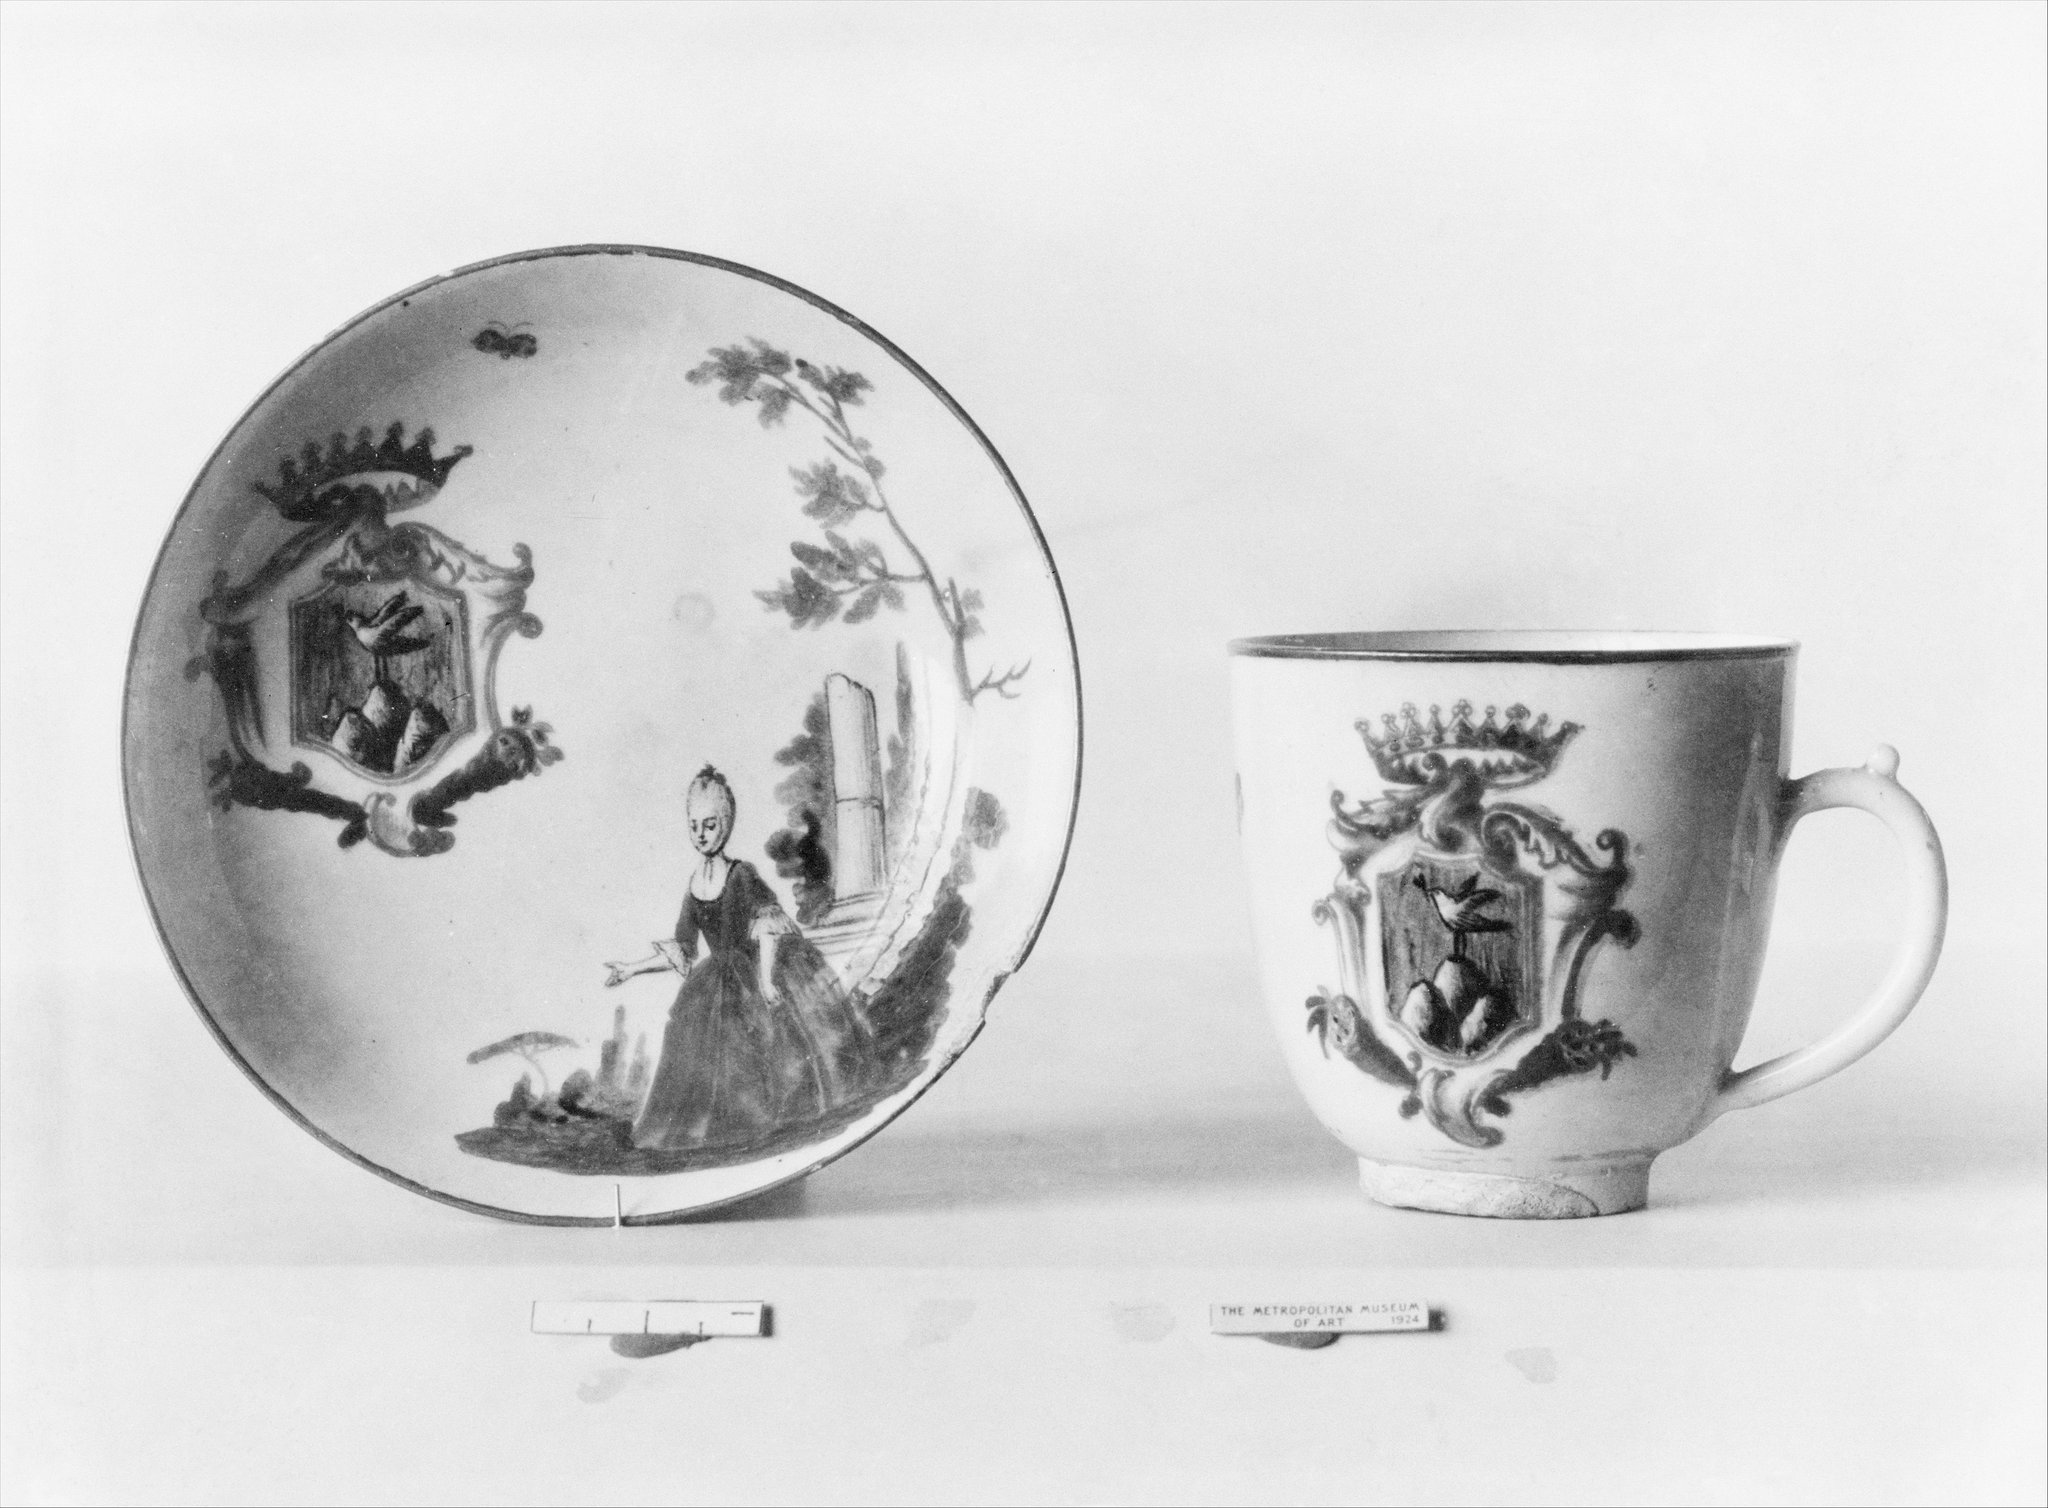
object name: cup and saucer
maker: cozzi manufactory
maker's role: factory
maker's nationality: italian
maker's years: 1764-1812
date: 1770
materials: hard paste porcelain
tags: birds,women,coat of arms